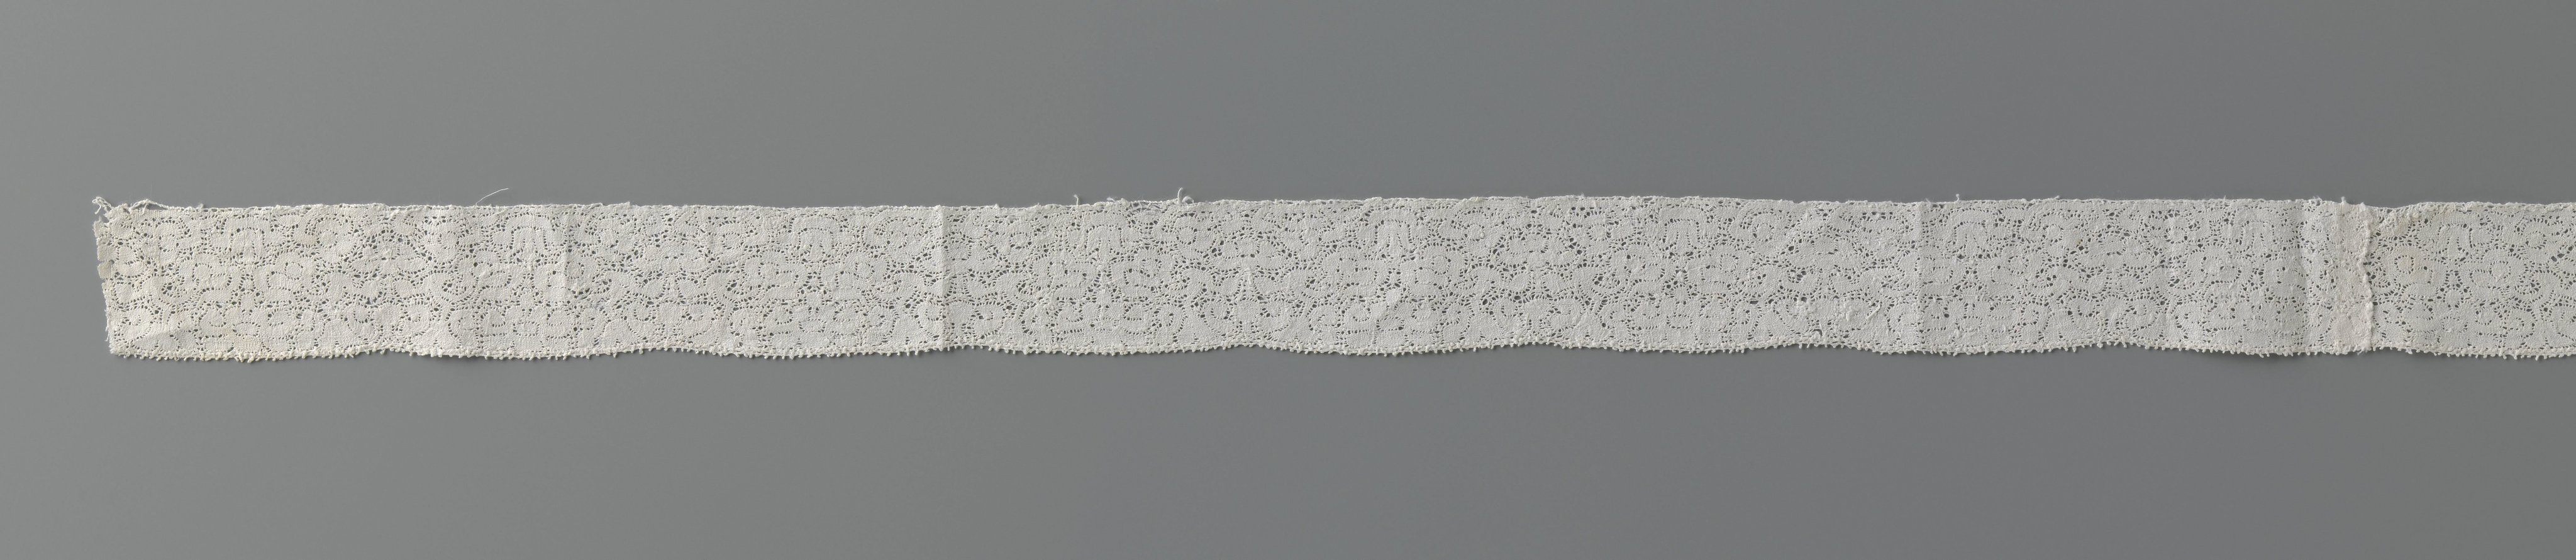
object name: strip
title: Strook kloskant met symmetrische composities opgebouwd uit kleine florale motiefjes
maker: Anonymous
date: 1650-1699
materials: linen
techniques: lace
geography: antwerp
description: Strook naturelkleurige Hollandse kloskant. Het zich herhalende patroon bestaat uit twee in elkaar overlopende symmetrische composities waarbij de motieven dicht tegen elkaar aan staan. De ene compositie bestaat langs de bovenzijde van de strook uit een omgekeerd kelkbloempje of tulpje. Daaronder staan op de middenlijn twee naar elkaar toegewende wolkvormige bladeren met daaronder een rozetbloem langs de onderzijde van de strook. De andere compositie bestaat uit twee naar elkaar toegekeerde rozetbloempjes aan omkrullende steeltjes, waaronder een waaiervormige bloem en daaronder een knopvormige bloem tussen twee voluutblaadjes langs de onderzijde. De motieven zijn gemaakt in linnenslag met opengewerkte randjes. Er is niet of nauwelijks sprake van een grond. De motieven zijn dicht tegen elkaar aan geplaatst, soms gescheiden door een soort korte dikke vlechtjes. De bovenzijde van de strook is recht afgewerkt. De onderzijde van de strook heeft zeer vlakke brede schulpen die zijn afgewerkt met picots.